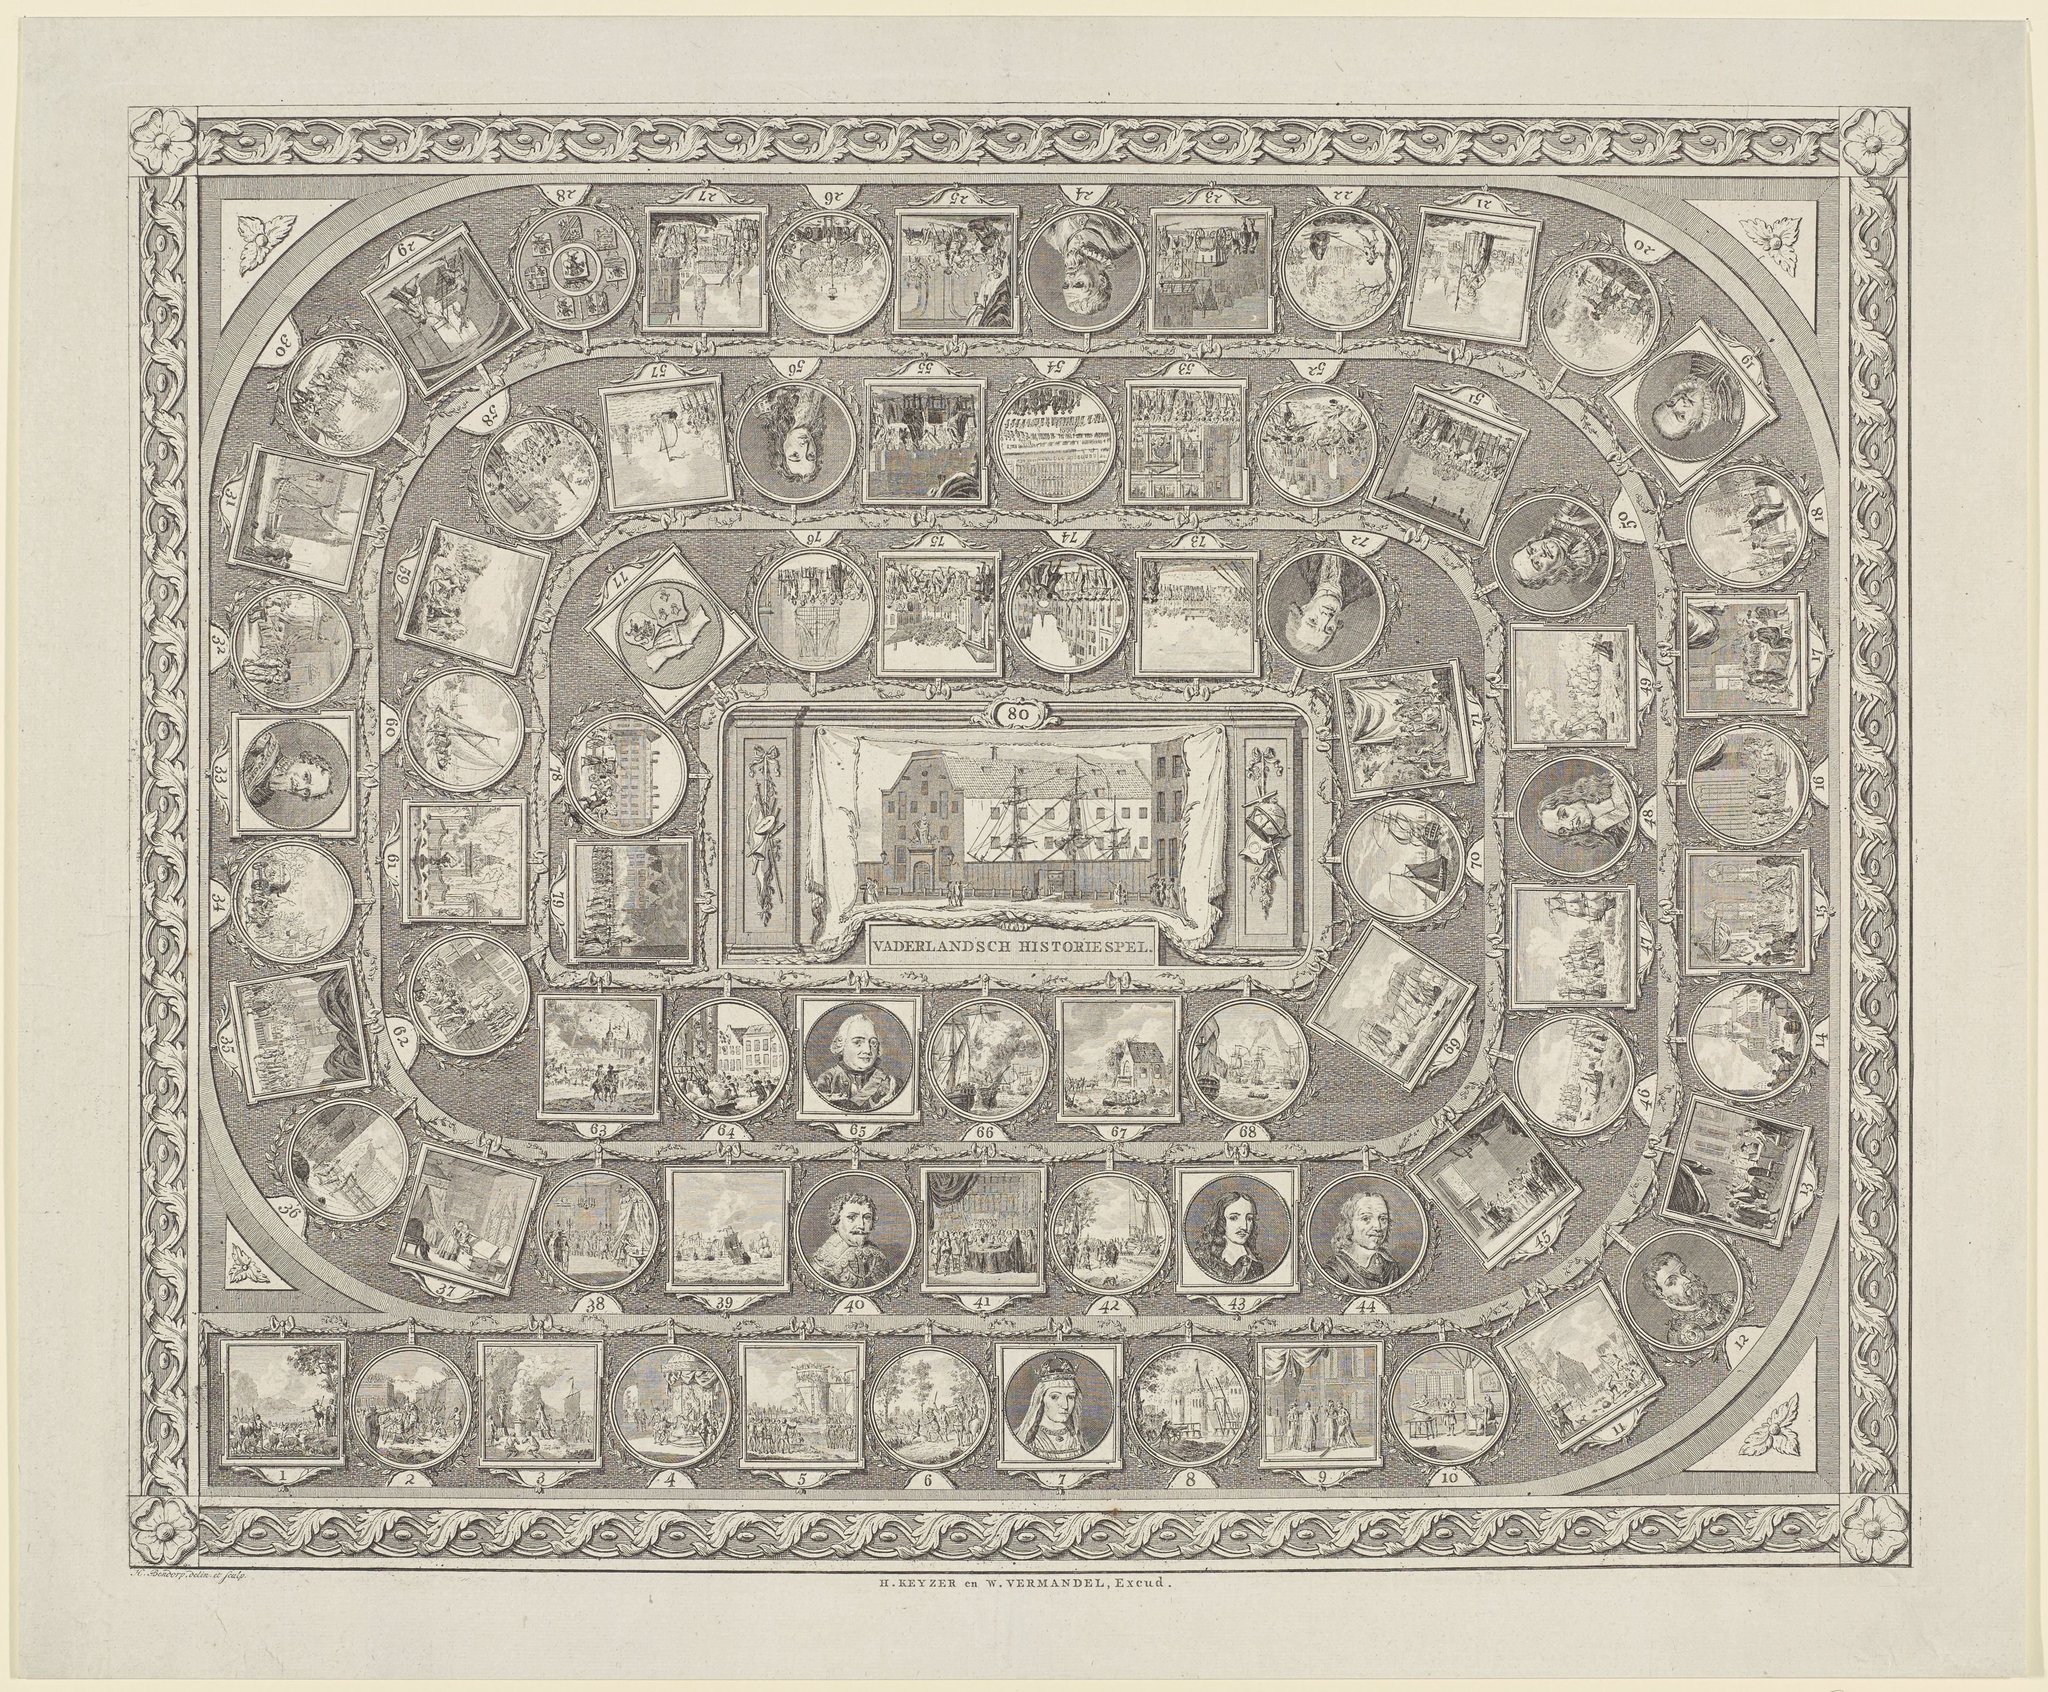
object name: print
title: Vaderlands Historiespel, 1787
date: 1787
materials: paper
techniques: engraving, etching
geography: amsterdam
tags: goose-game, patriots (1780-1795)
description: Patriots bordspel over de vaderlandse geschiedenis. Ganzenbord met 80 genummerde vakjes beginnend bij 1 (Bataafse Opstand) en lopende tot en met 80 (Kweekschool voor de Zeevaart te Amsterdam). De meest recente afgebeelde gebeurtenissen zijn uit het jaar 1787. Bij het spel behoort een aparte verklaring.